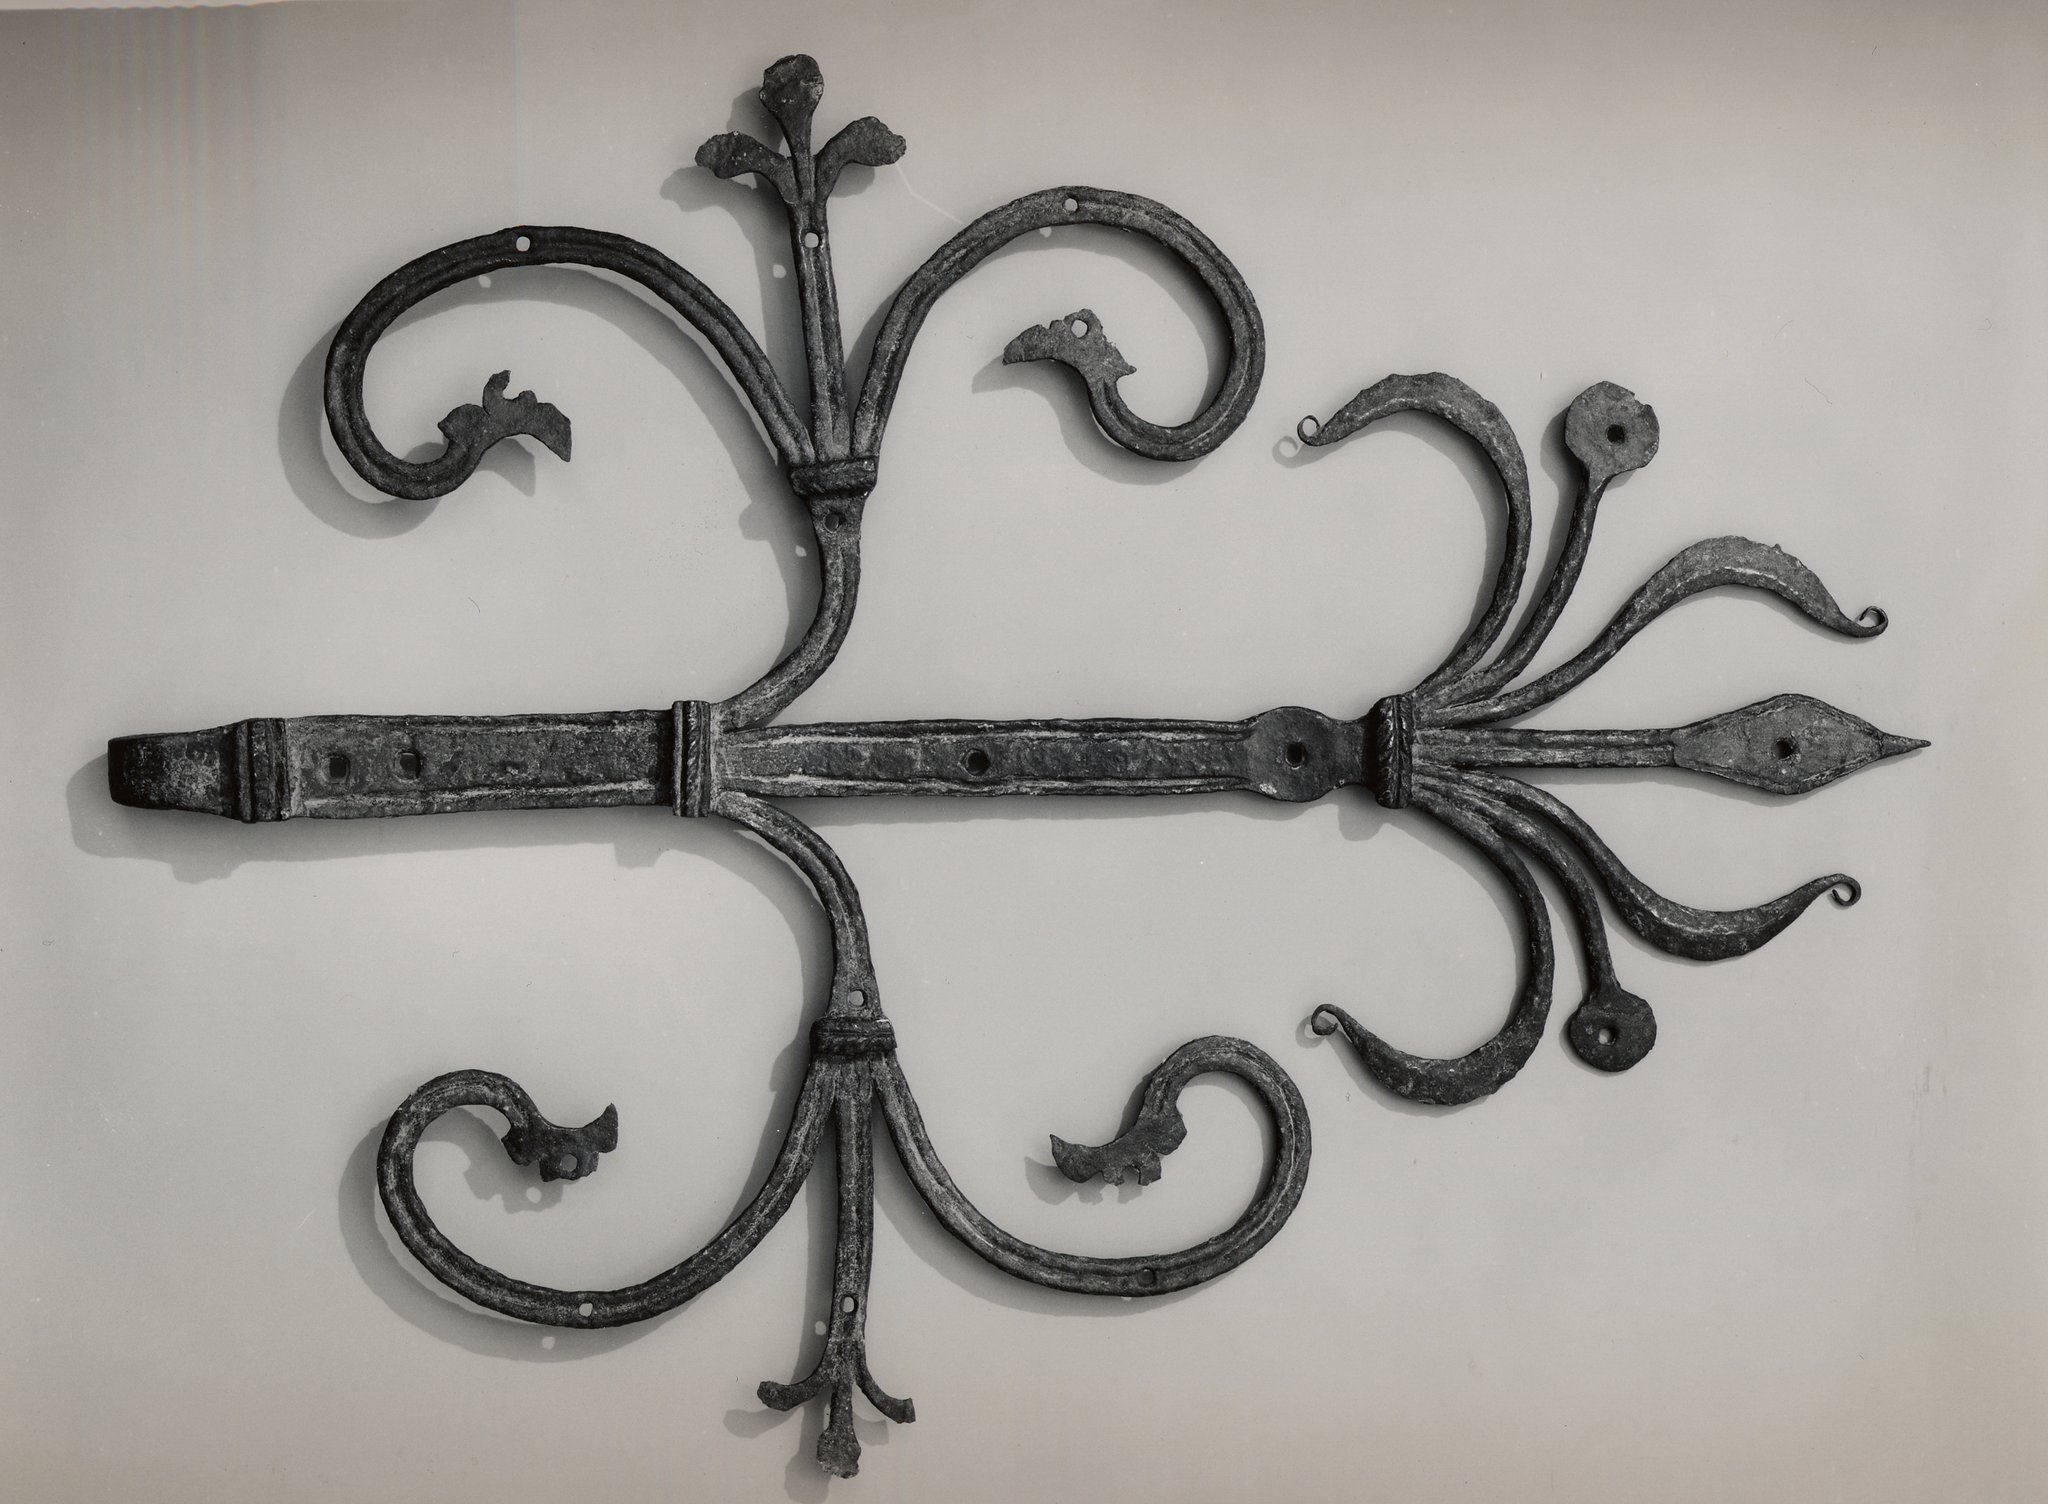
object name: hinge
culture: european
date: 1401-1600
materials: iron